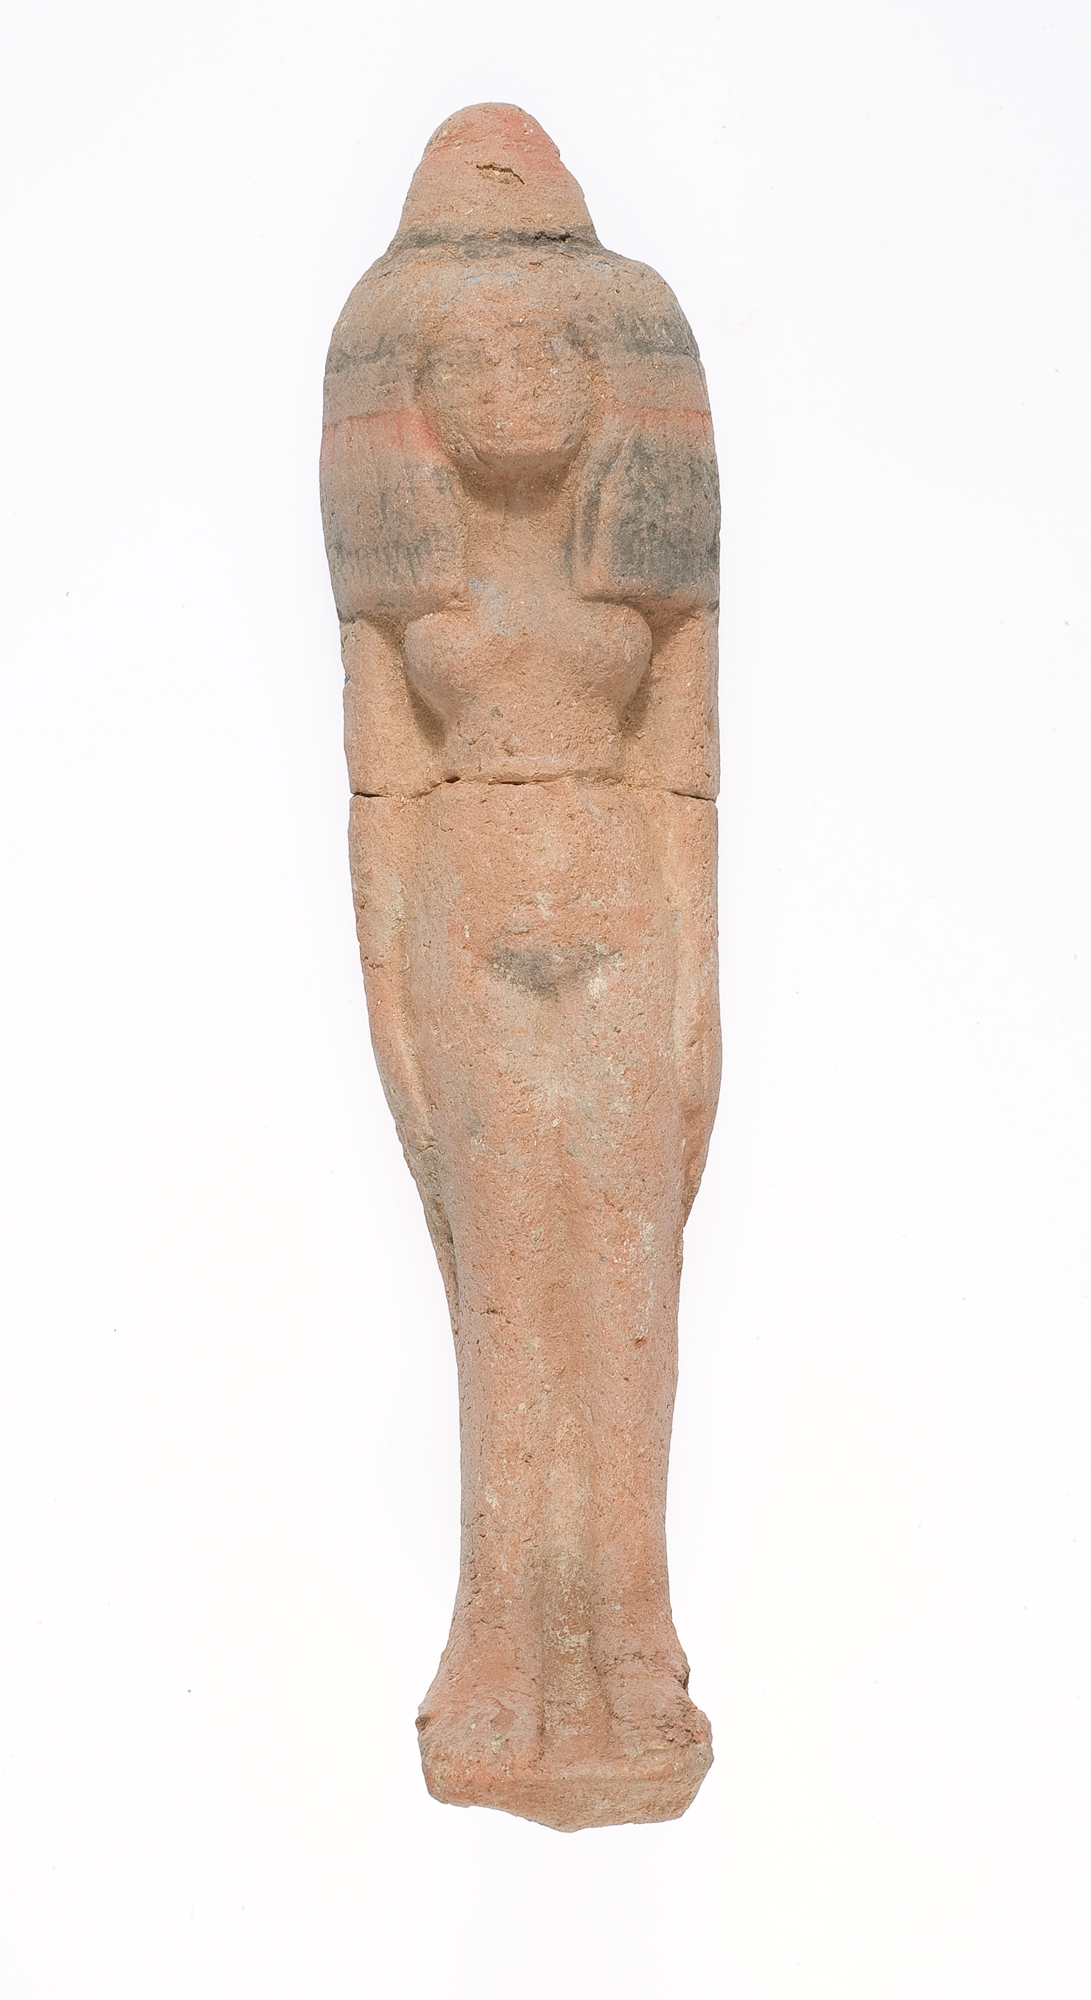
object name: statuette of a woman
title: Standing female figurine wearing large headdress and wax cone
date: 1390-1186 BCE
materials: pottery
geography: egypt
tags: women